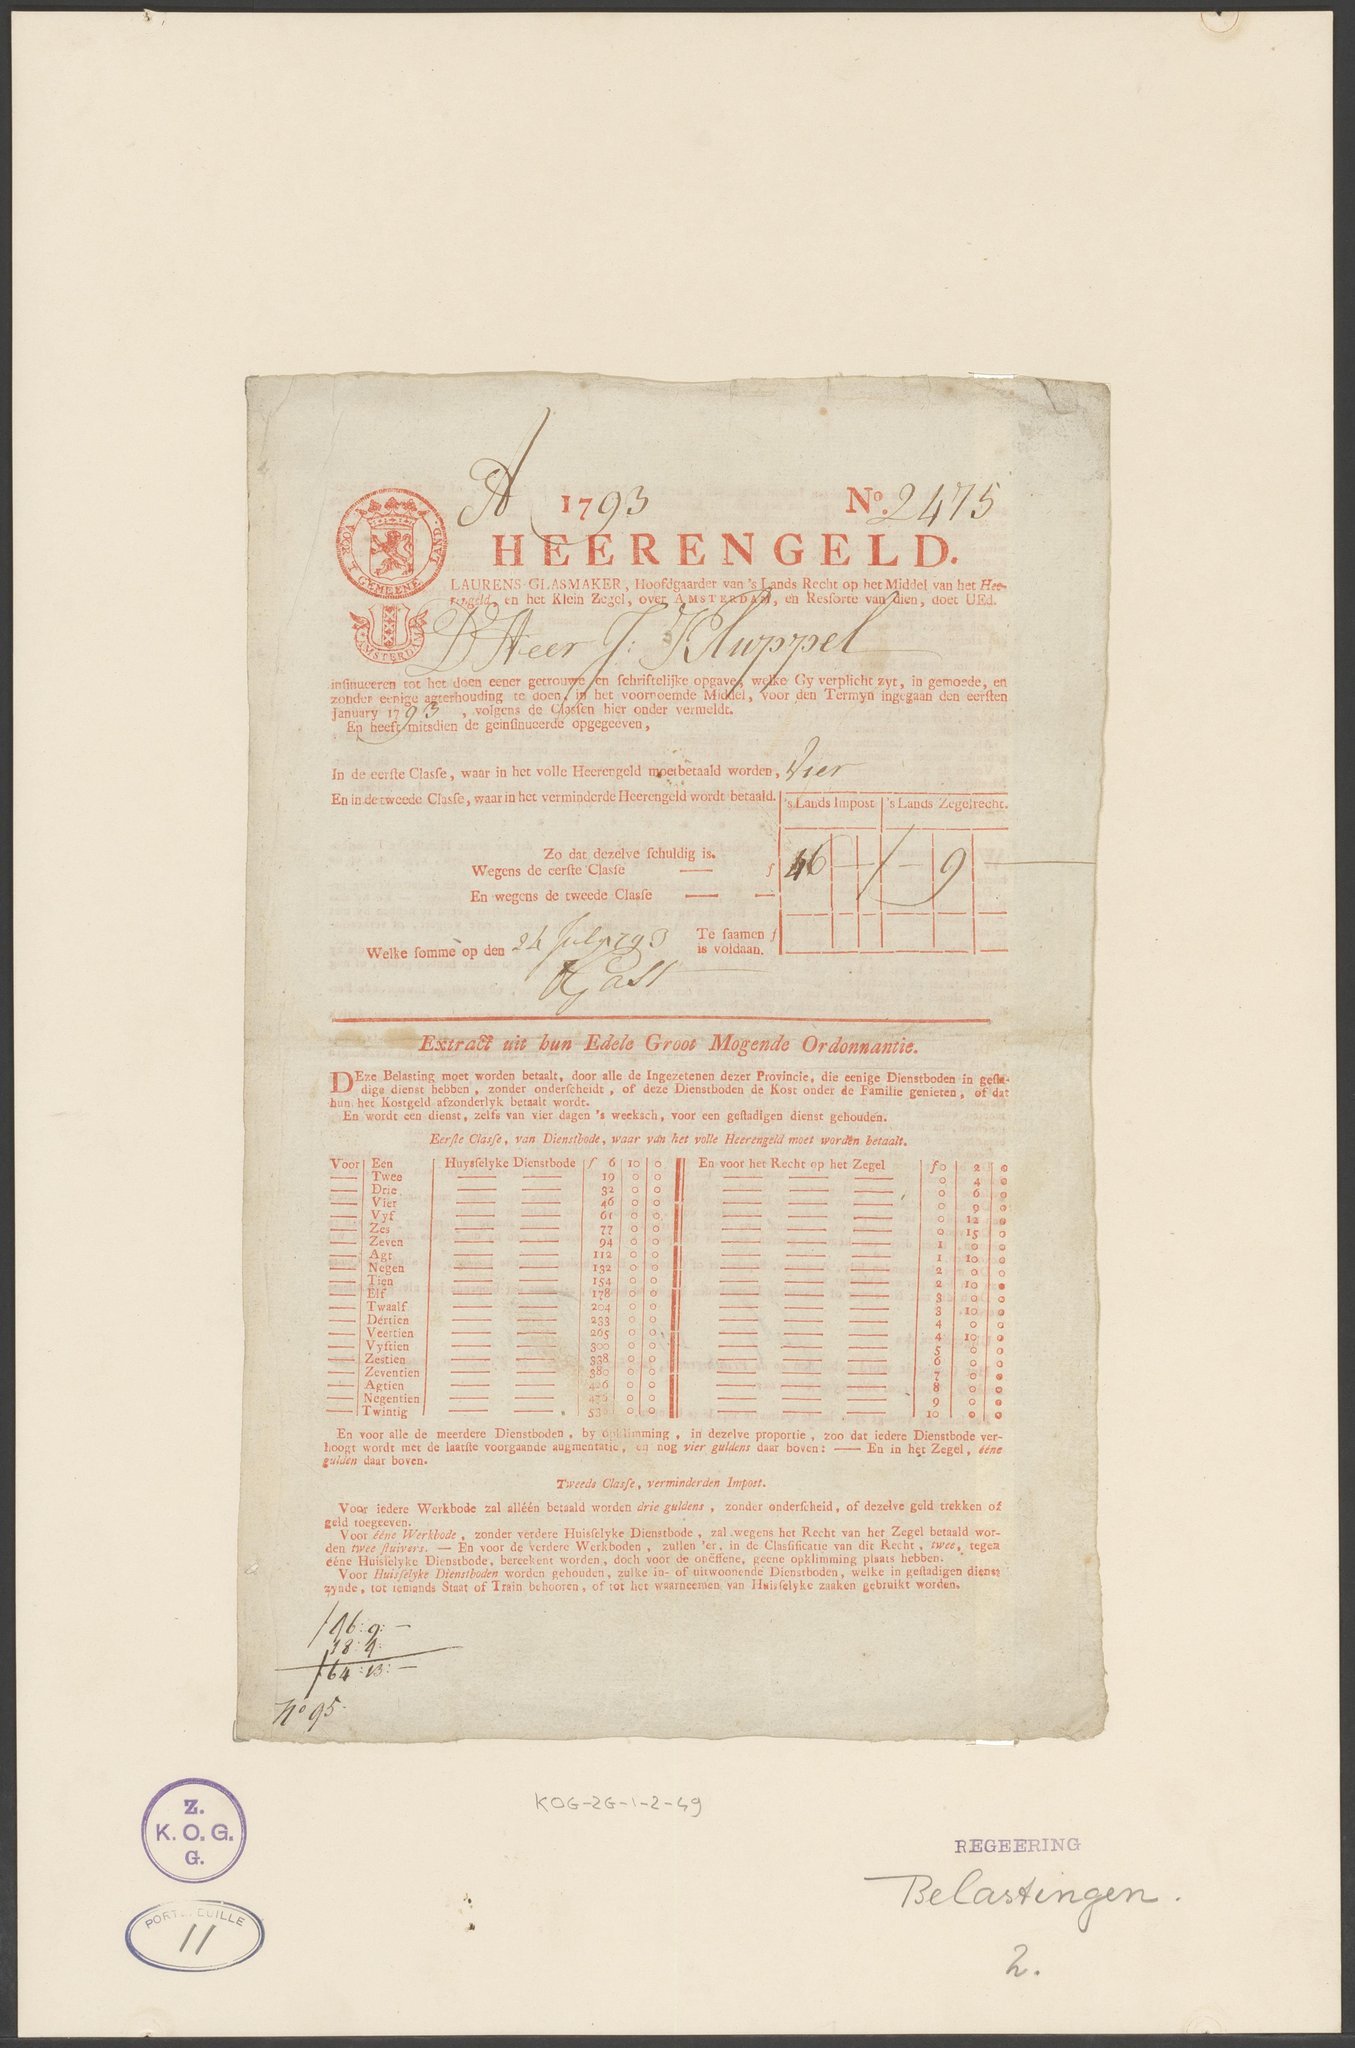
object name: text sheet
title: Aanslagbiljet van het Heerengeld, 1793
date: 1793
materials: paper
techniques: letterpress printing, pen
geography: amsterdam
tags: tax collection, amsterdam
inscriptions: collector's mark: Lugt 1641, collector's mark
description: Aanslagbiljet van het Heerengeld, nr. 2475, op naam van dhr. J. Kluppel, Amsterdam 19 juli 1793. Voorgedrukt formulier gedrukt in rood, beide zijden bedrukt, ingevuld en ondertekend met pen. Onderwerpsrubrieken binnen de Atlas Zeden en Gewoonten: Regeering, Belasting.